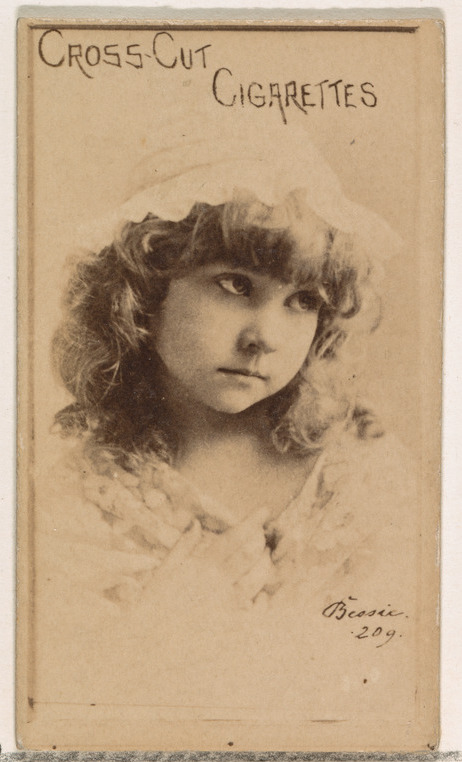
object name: print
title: Card Number 209, Bessie, from the Actors and Actresses series (N145-1) issued by Duke Sons & Co. to promote Cross Cut Cigarettes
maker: w. duke, sons & co.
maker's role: publisher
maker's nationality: american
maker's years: 1870-1920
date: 1880-1889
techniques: albumen silver print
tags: girls,portraits,actresses